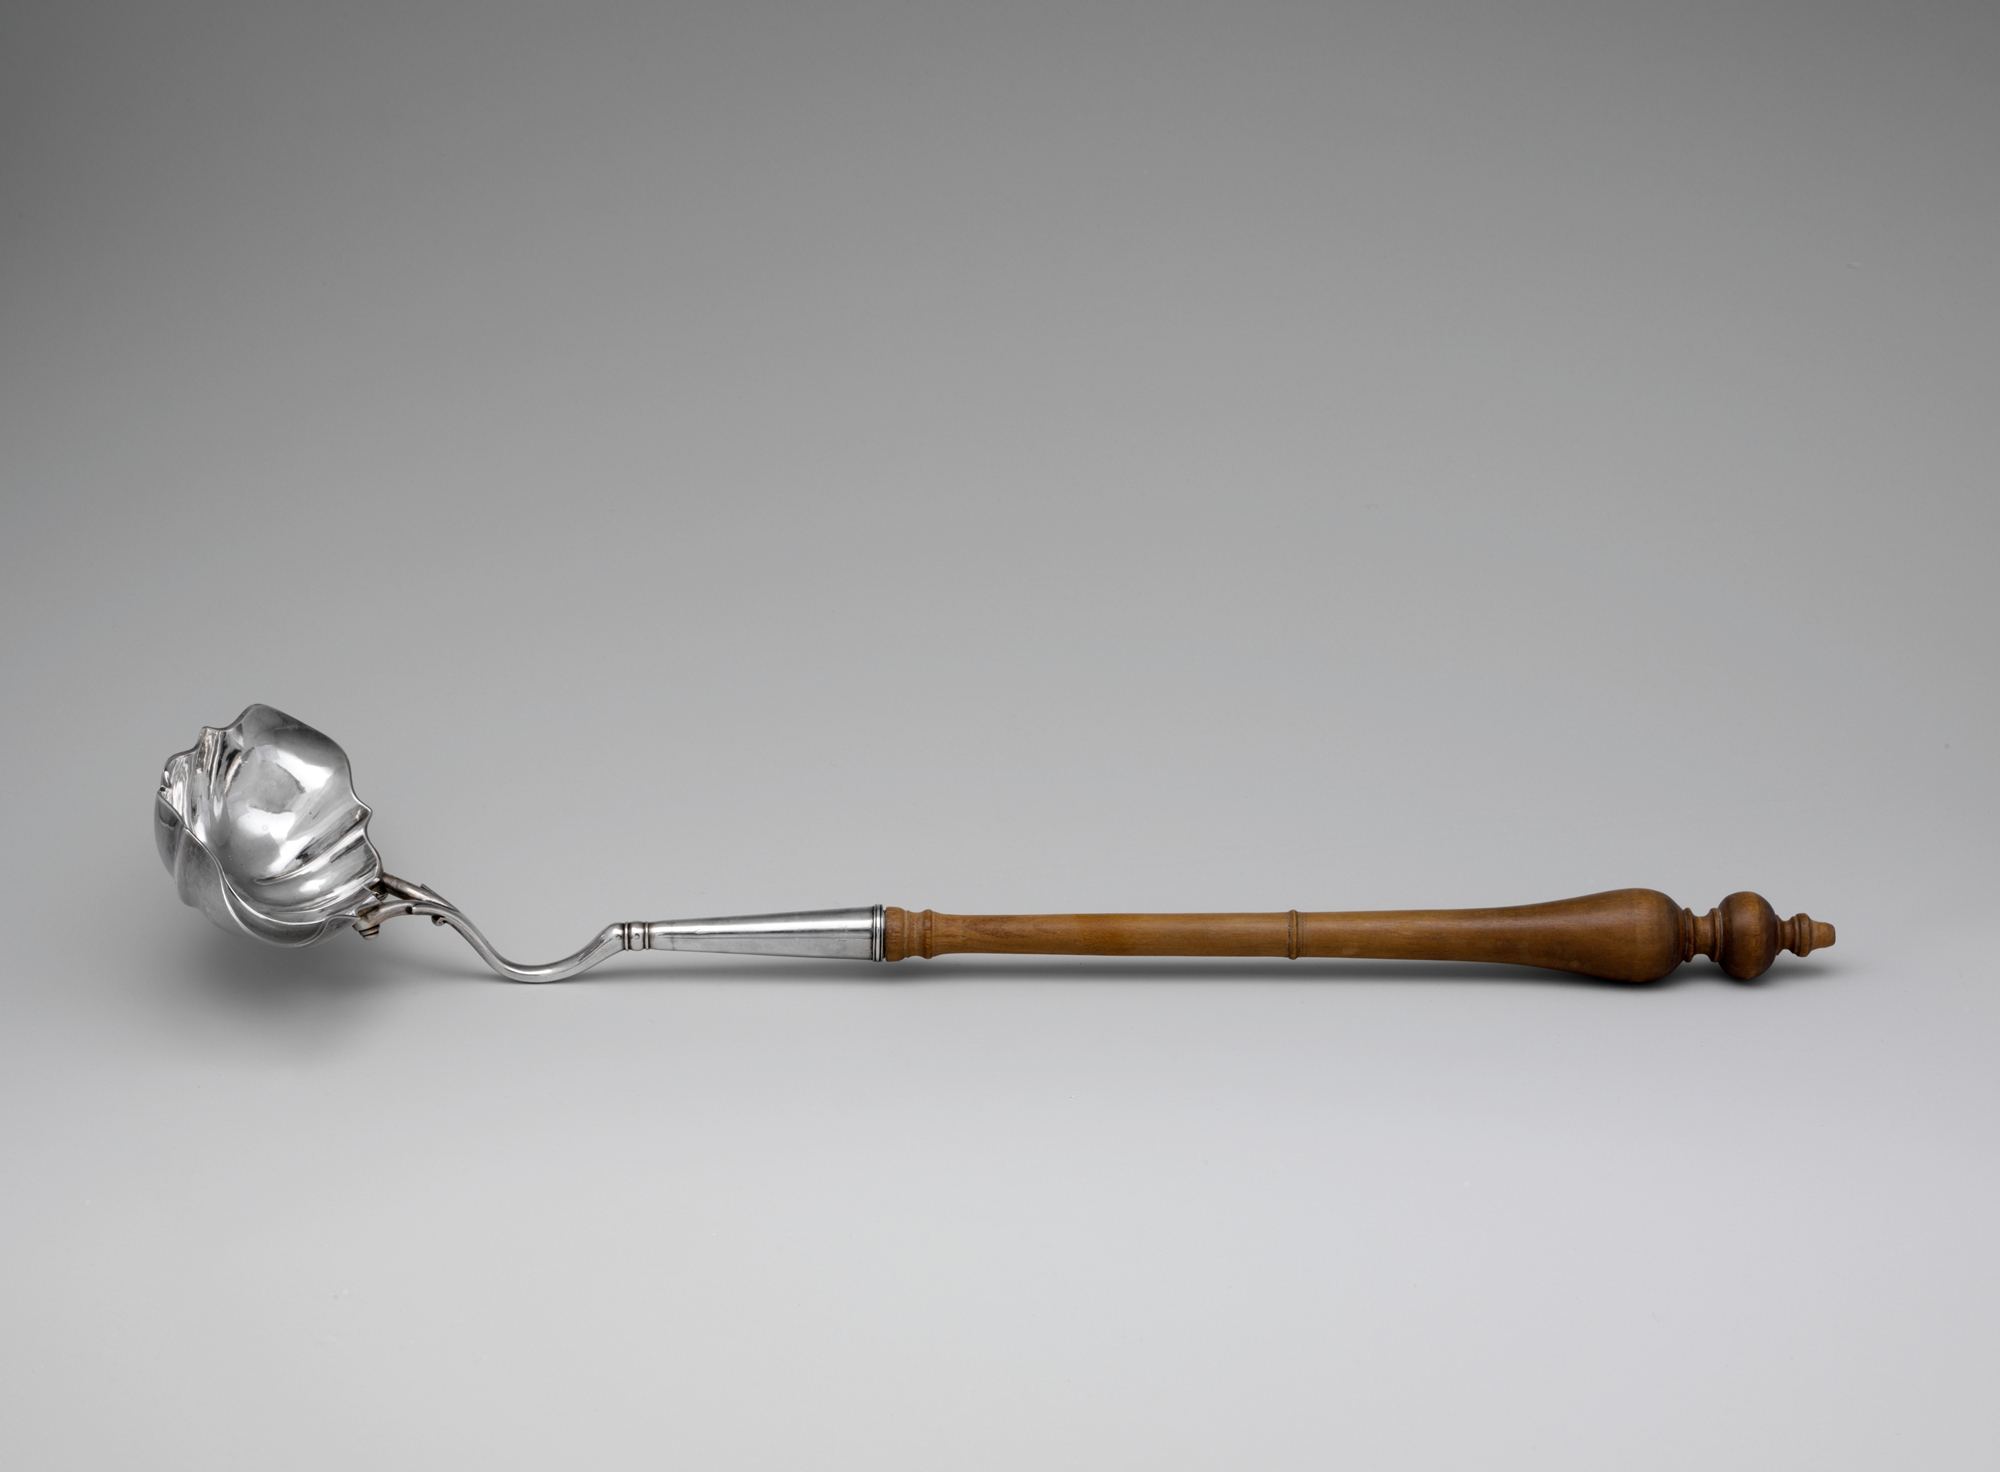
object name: ladle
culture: american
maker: samuel edwards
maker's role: maker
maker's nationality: american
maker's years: 1705-1762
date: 1745-1760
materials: silver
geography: united states